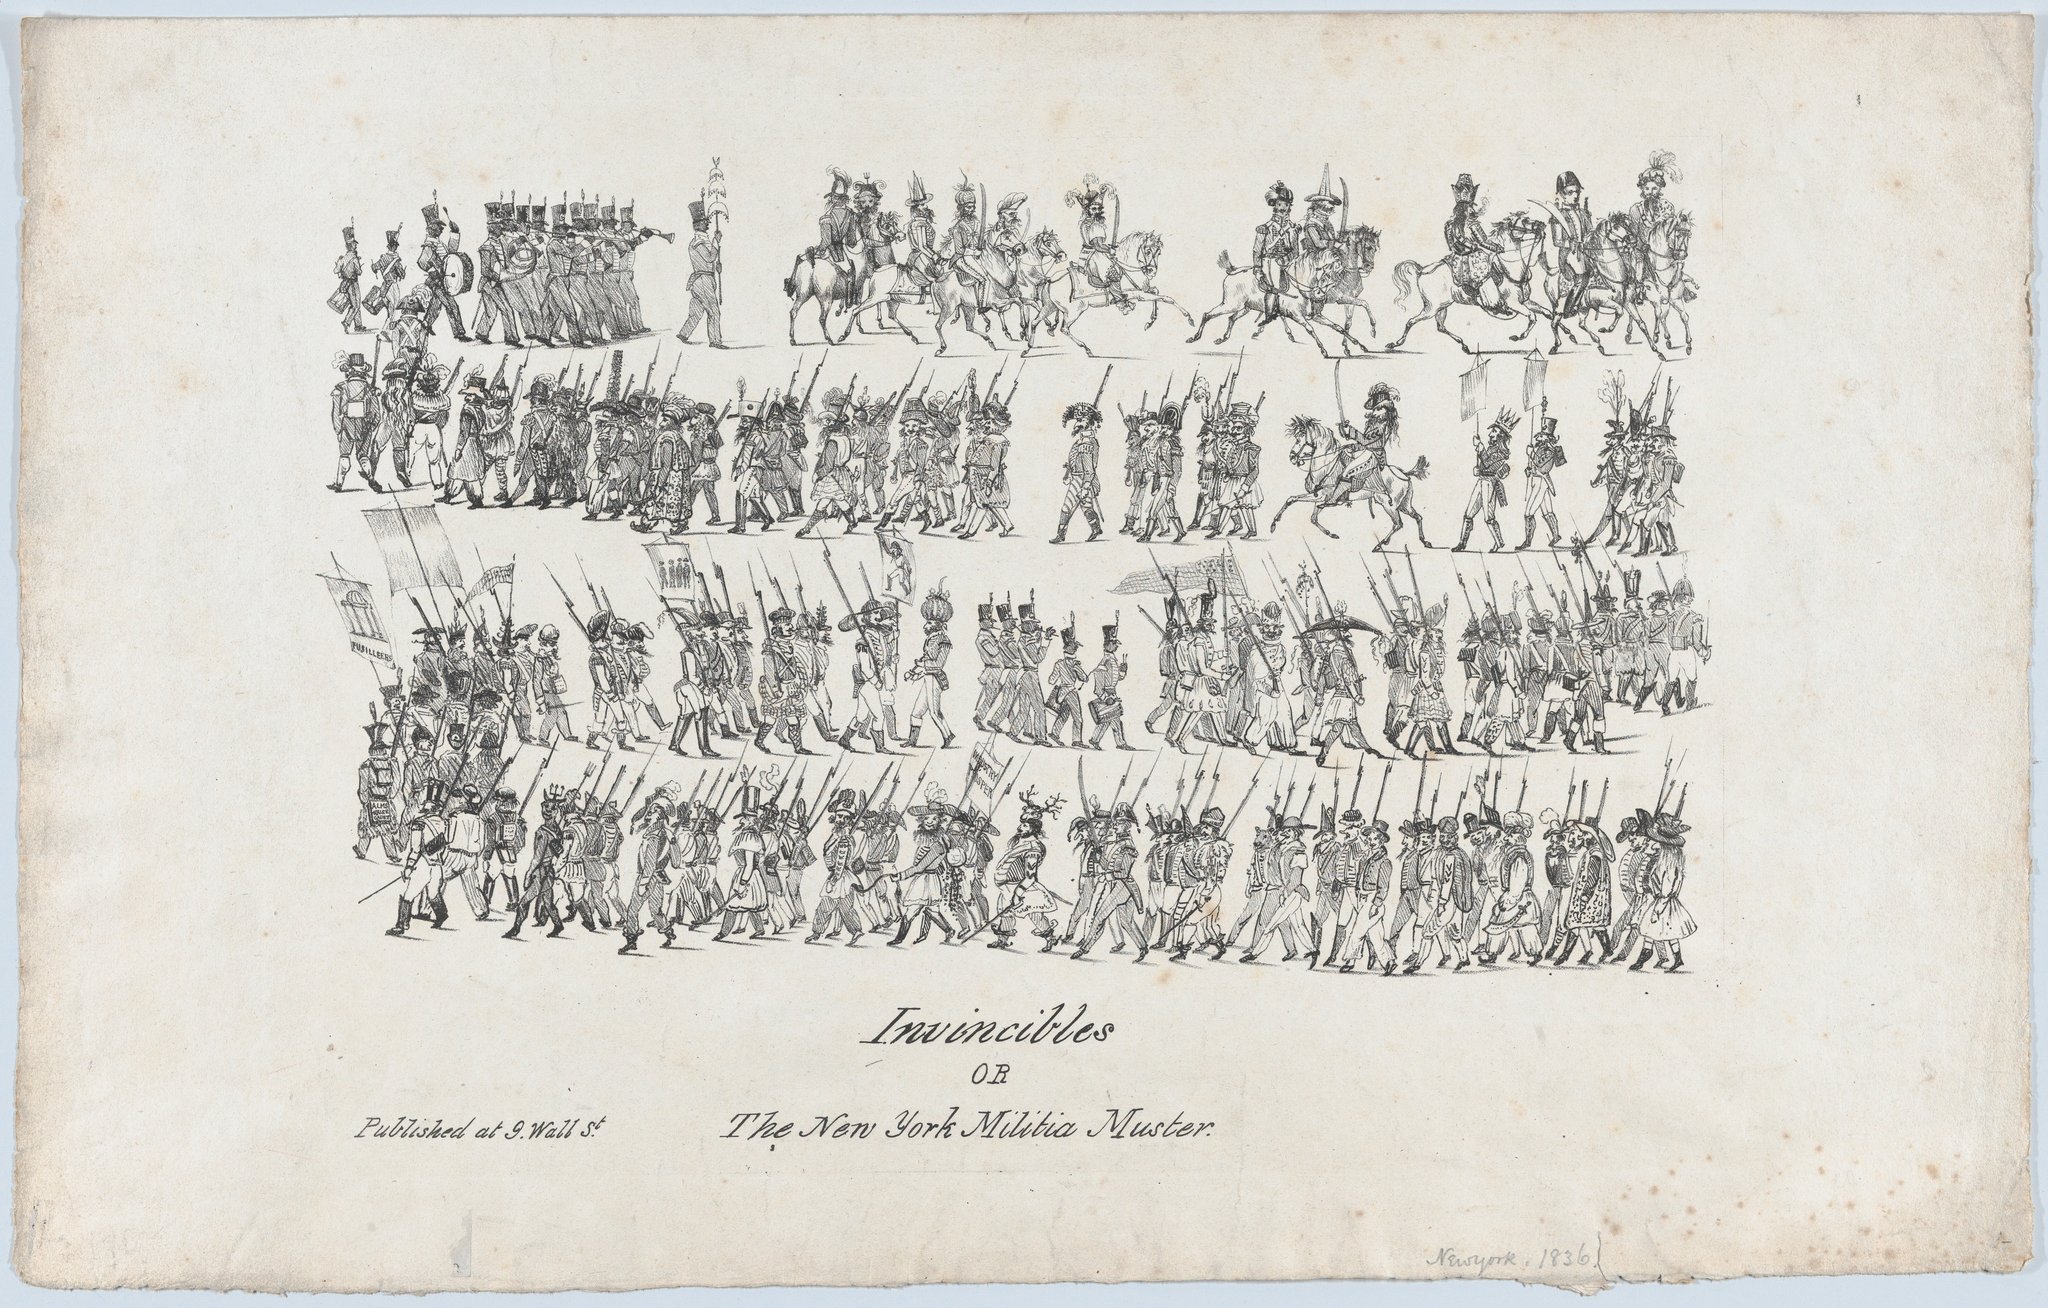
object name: print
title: Invincibles, or, The New York Militia Muster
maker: anonymous, american, 19th century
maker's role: artist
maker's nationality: american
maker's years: 1800-1900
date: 1836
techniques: lithograph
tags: musical instruments,military,horses